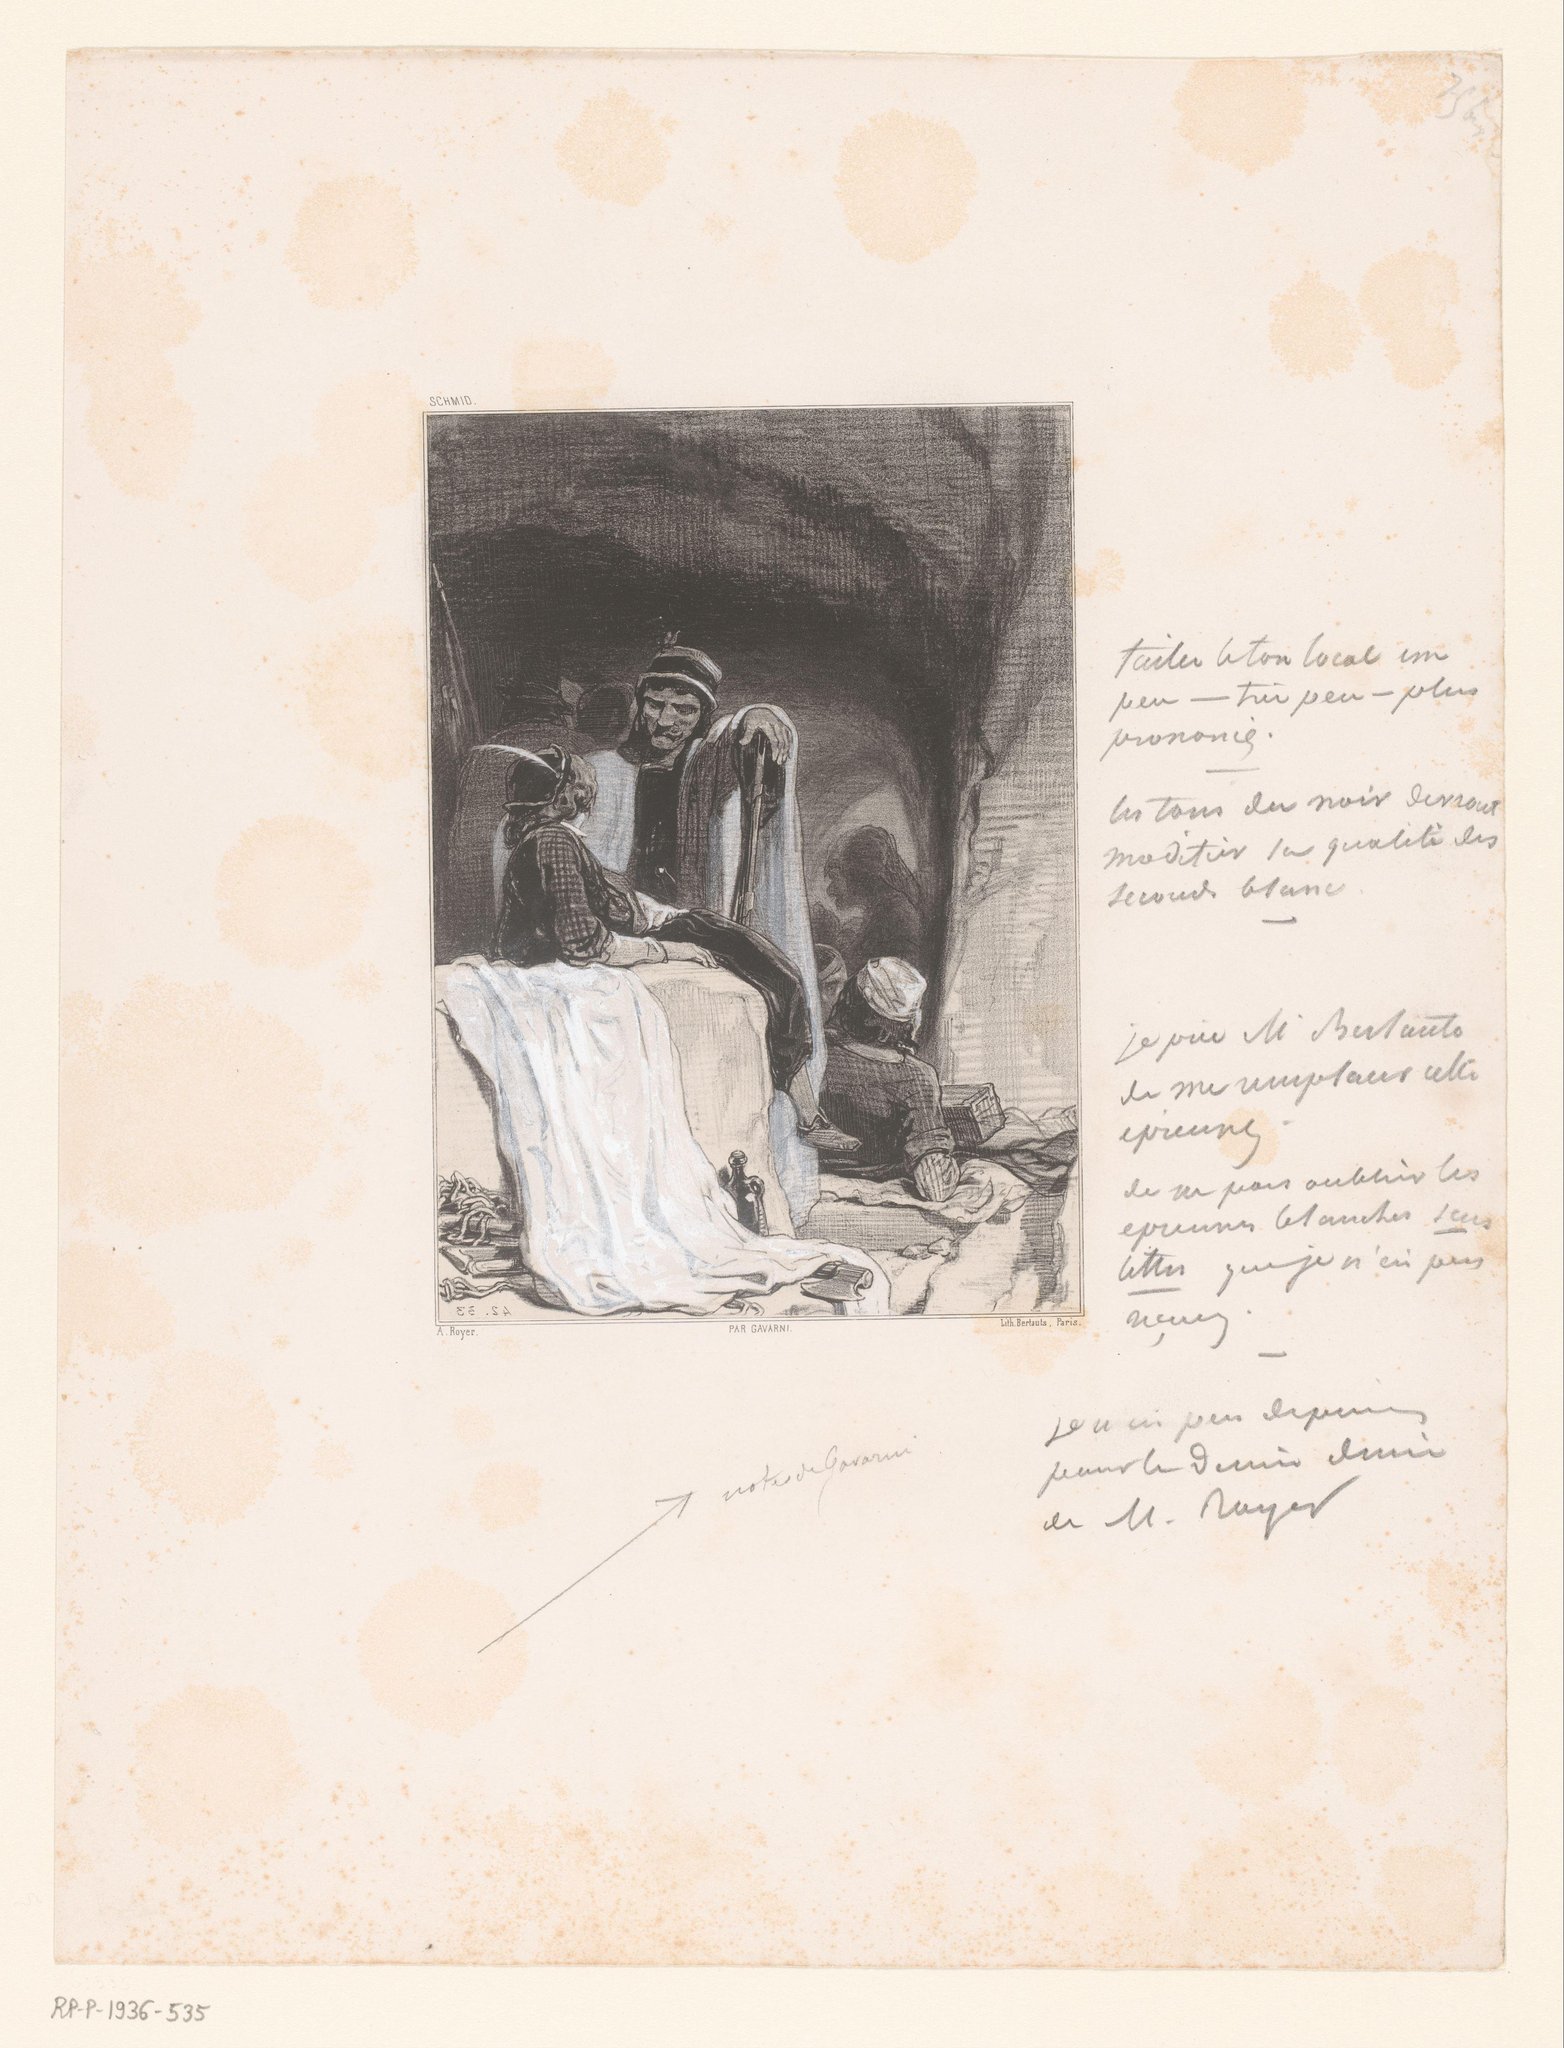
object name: print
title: Rovers in een grot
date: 1841-1842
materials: paper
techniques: hand coloring, lithograph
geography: paris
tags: boy (child between toddler and youth), robber's cave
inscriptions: annotation: ‘taiter le ton local un peu - très peu - plus prononcie (...)’, collector's mark: Lugt 2228a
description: Illustratie bij Histoire de Henri d'Eichenfelds van Christoph von Schmid.